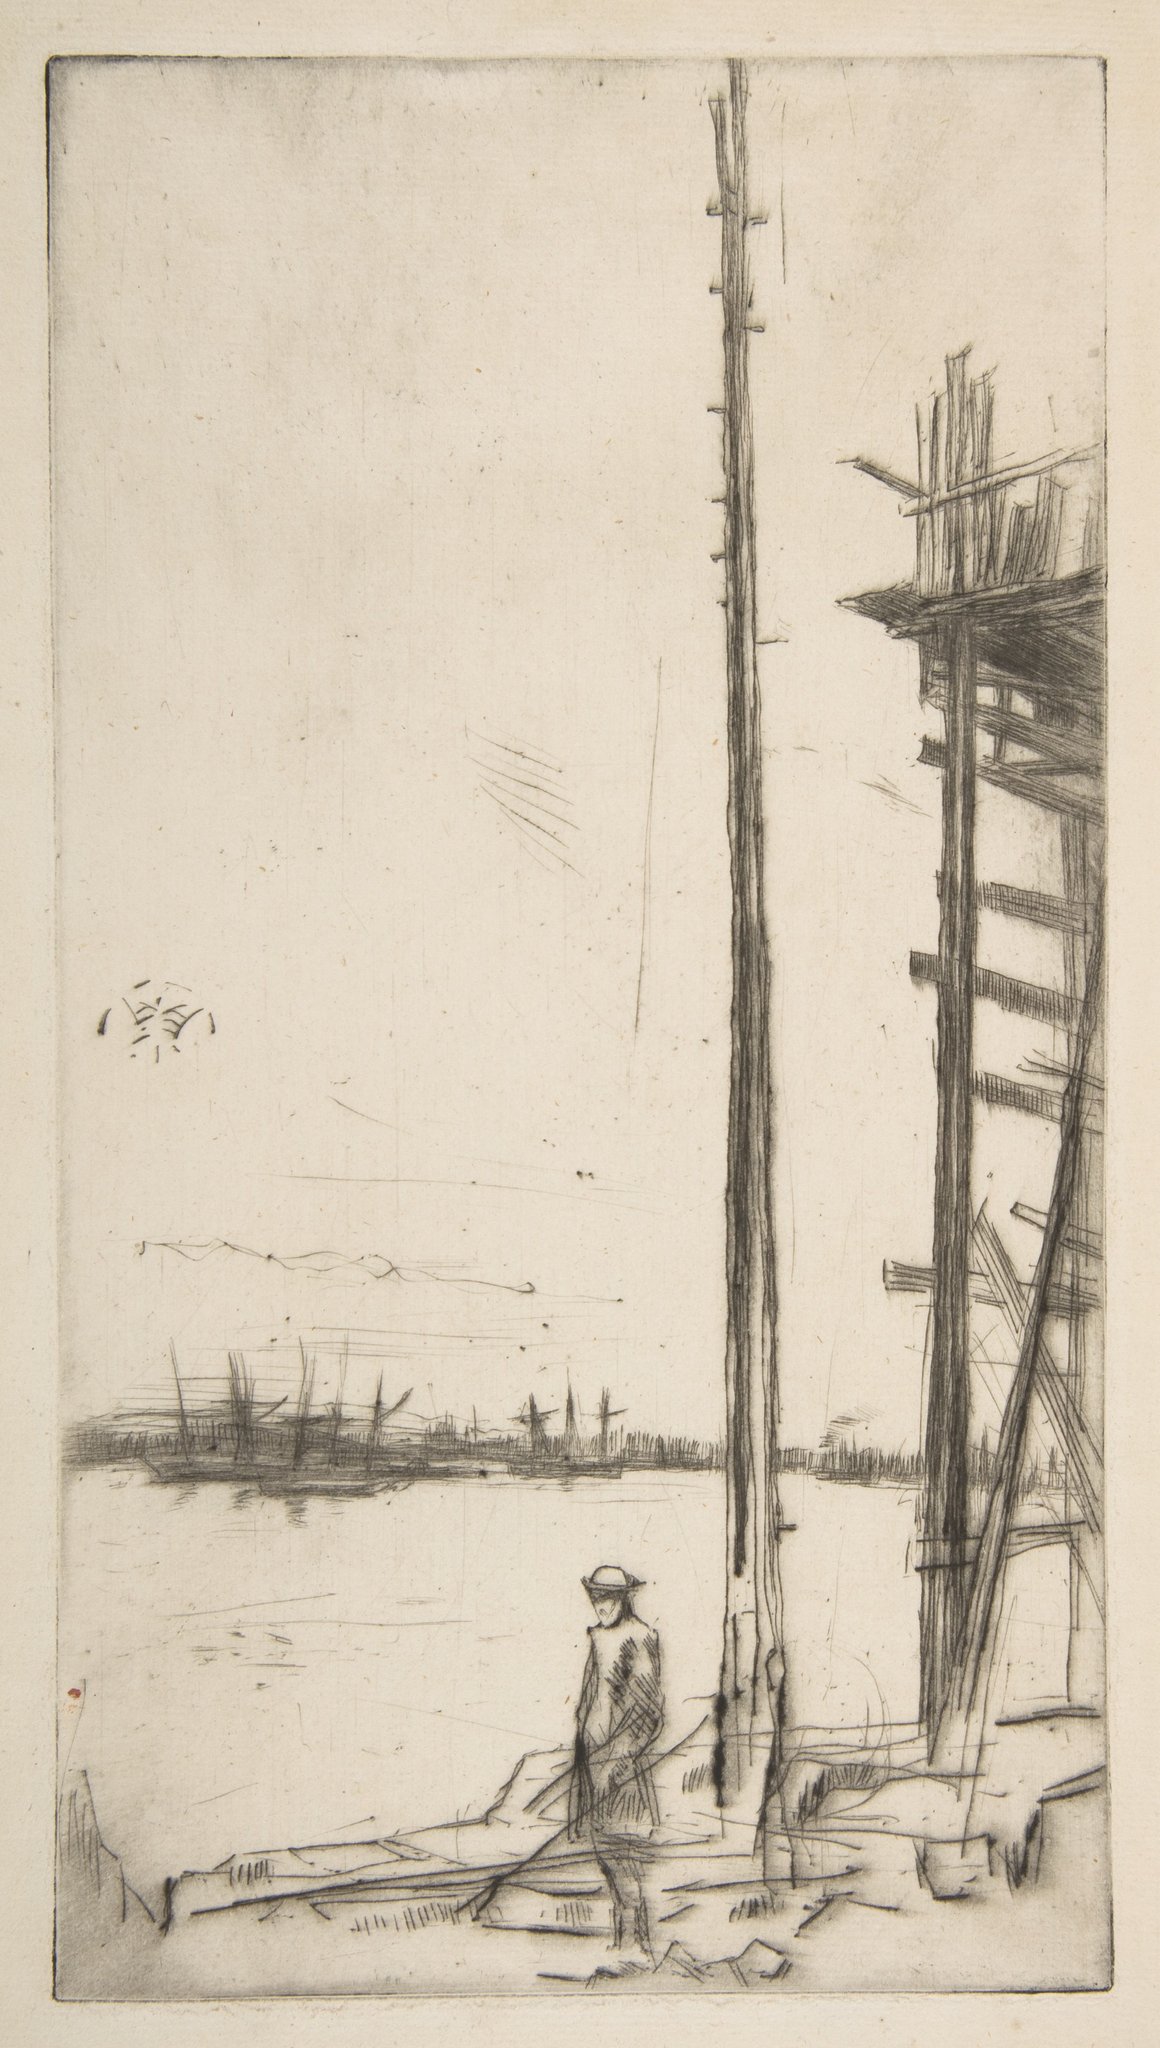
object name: print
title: Shipbuilder's Yard, Liverpool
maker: james mcneill whistler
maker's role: artist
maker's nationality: american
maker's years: 1834-1903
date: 1875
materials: ink, paper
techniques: drypoint, printing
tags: men,boats